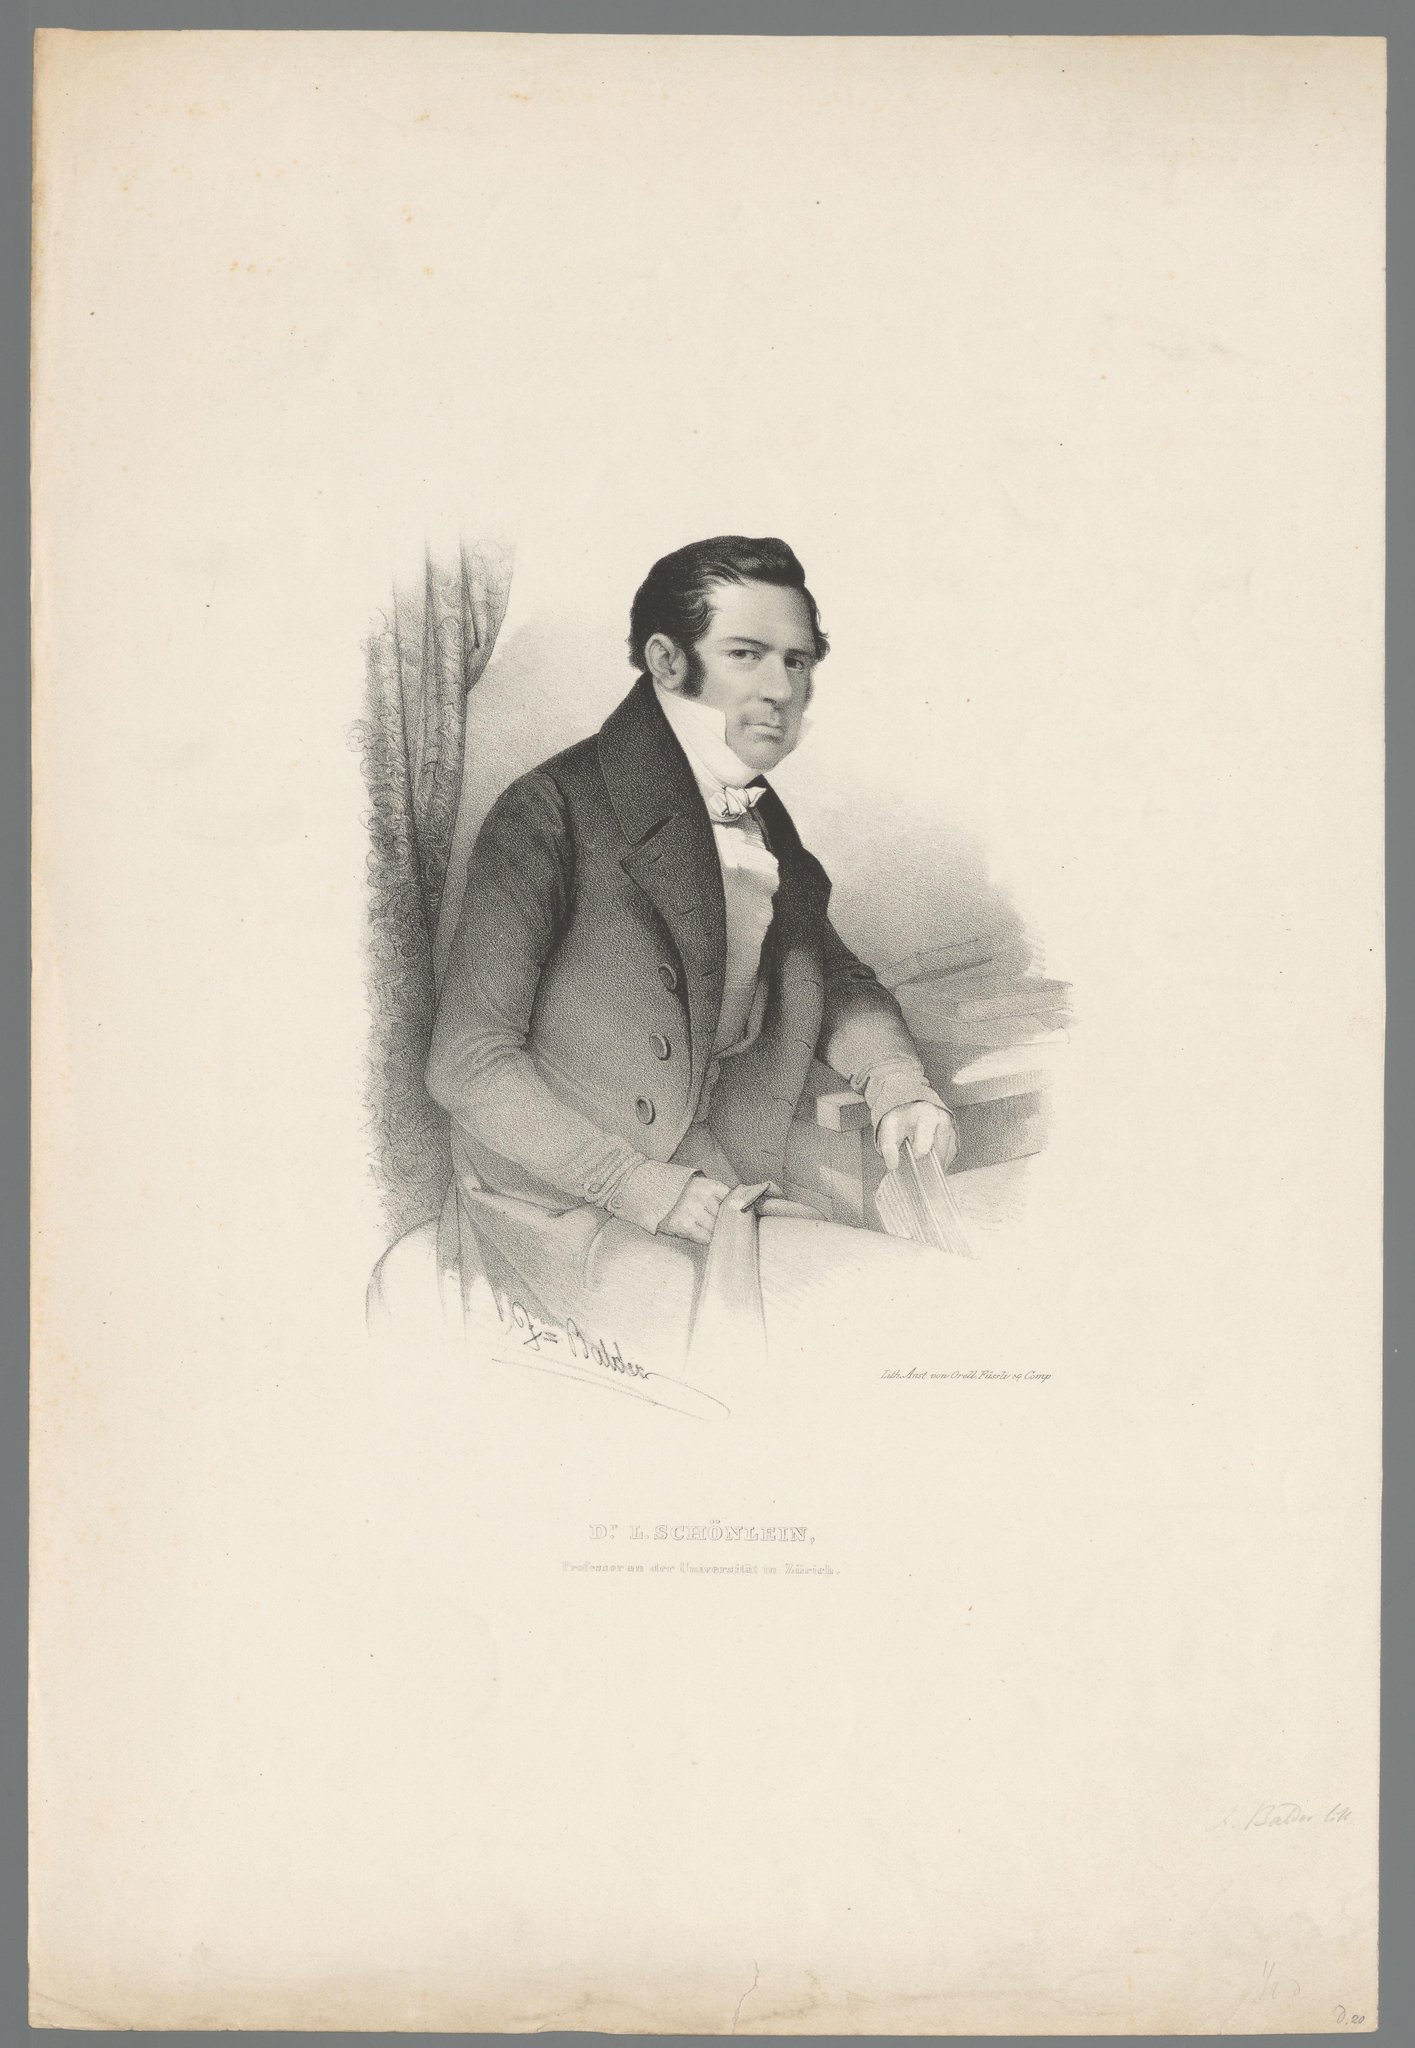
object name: print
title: Portret van Johann Lukas Schönlein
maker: georg balder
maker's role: print maker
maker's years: 1810-1882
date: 1820-1882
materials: paper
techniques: lithograph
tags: historical persons, medicine, medical science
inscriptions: collector's mark: Lugt 2228